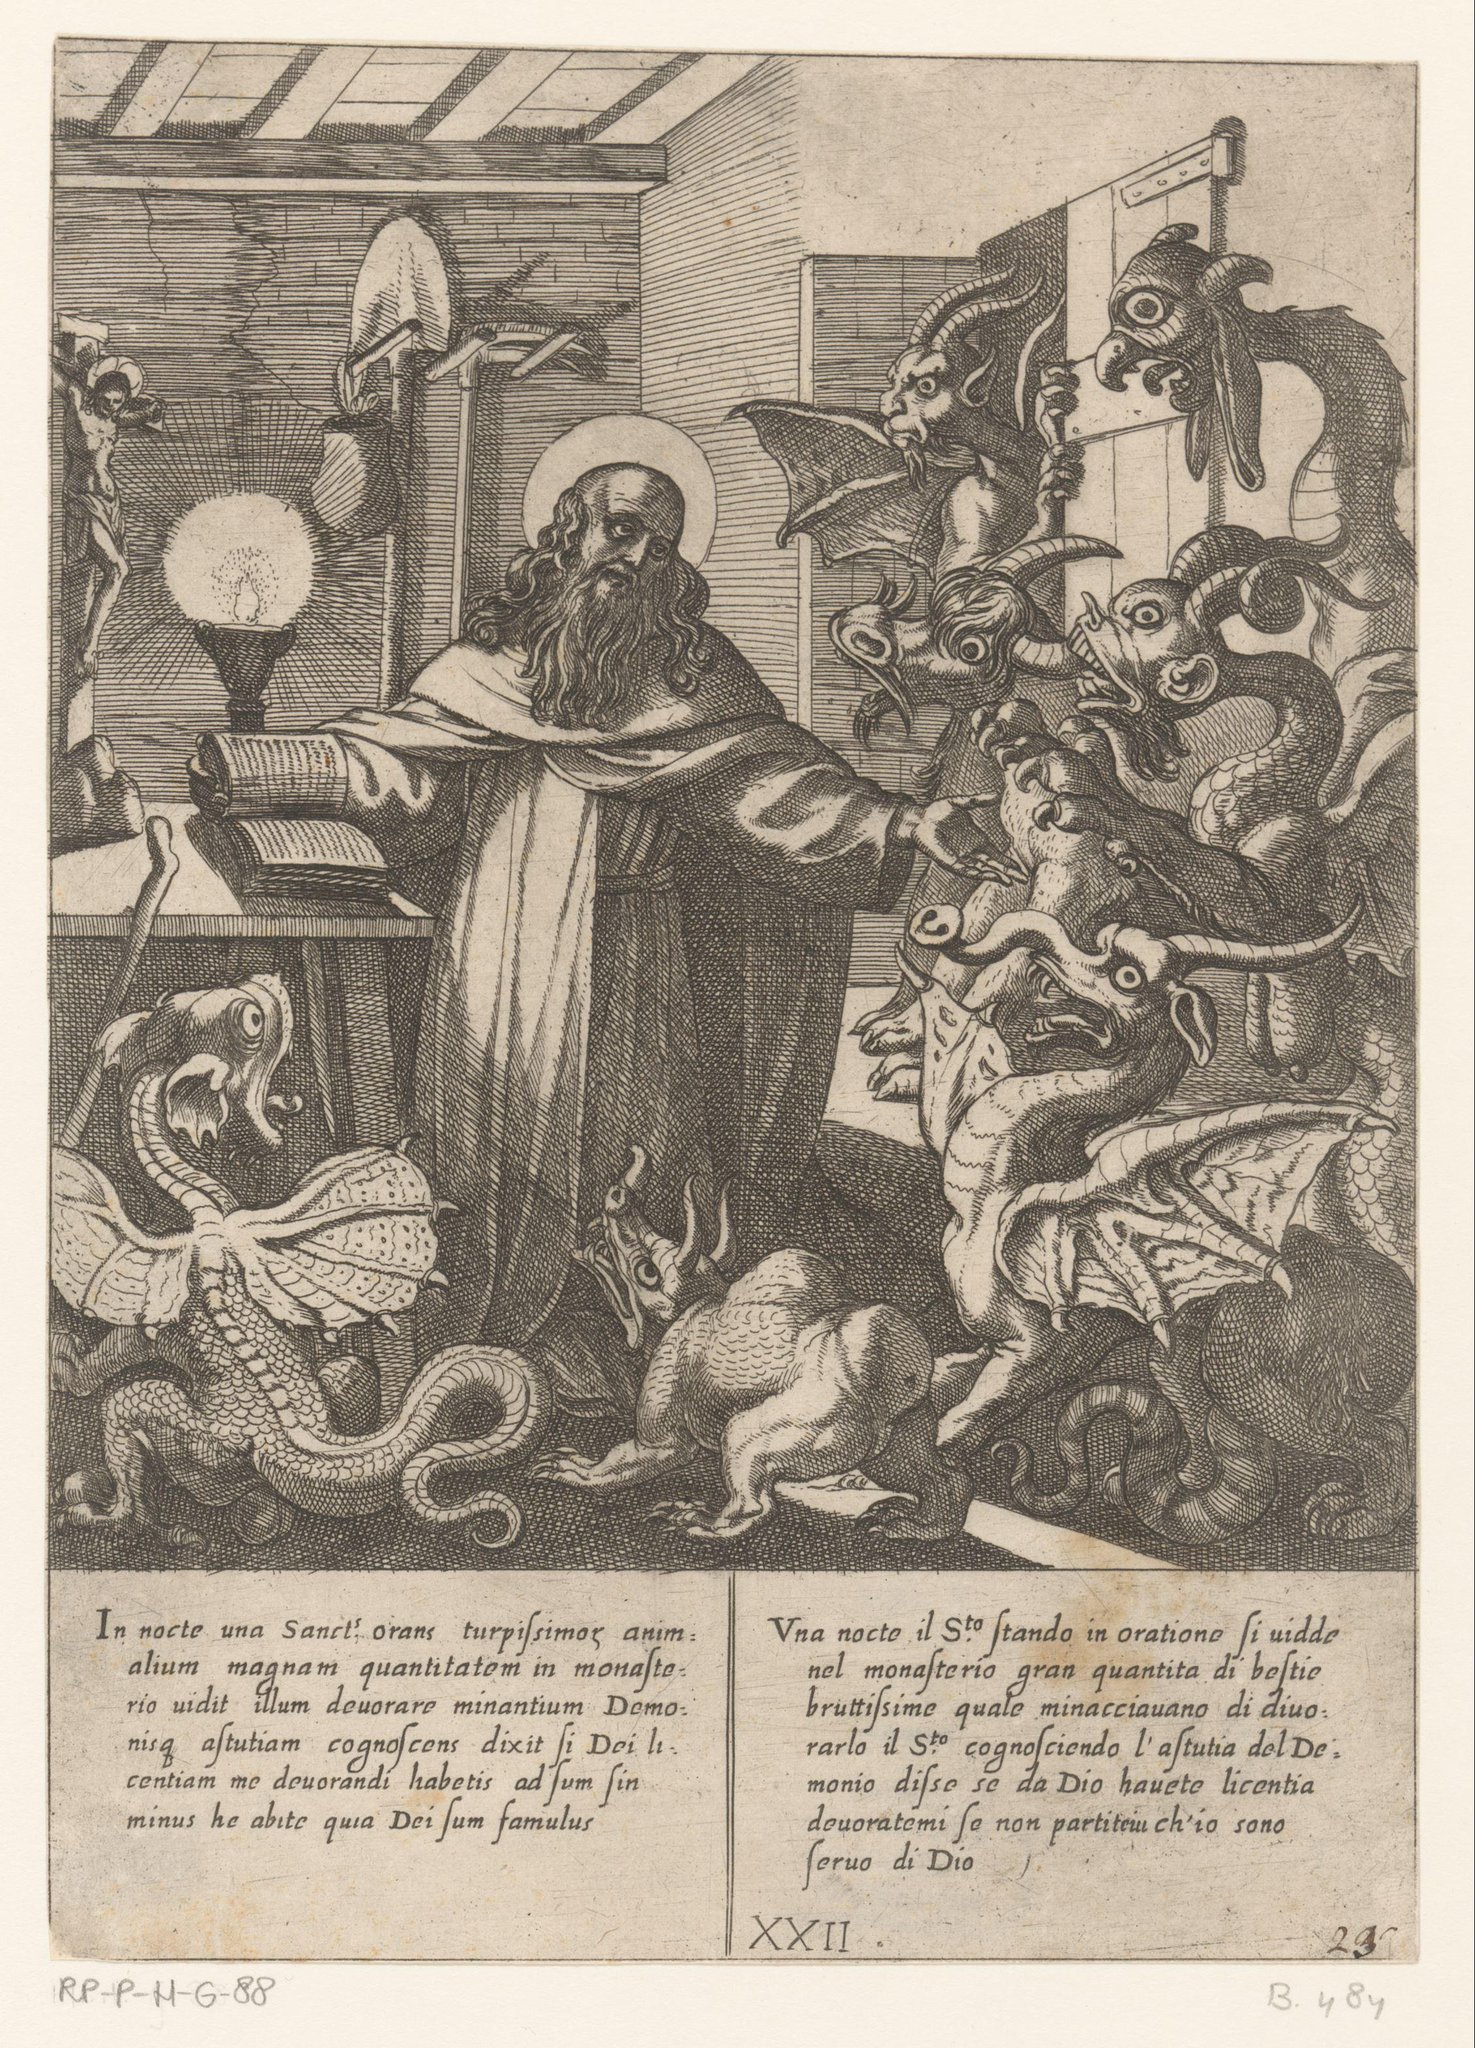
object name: print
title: Demonen dreigen H. Antonius te verslinden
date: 1598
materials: paper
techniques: etching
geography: rome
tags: devil(s) and demons, the hermit antony abbot (antonius abbas) of egypt, also called the great; possible attributes: bell, book, t-shaped staff, flames, pig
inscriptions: collector's mark: Lugt 11, number: ‘23’, collector's mark: ‘Hinloopen’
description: Deze prent maakt deel uit van een reeks van 27 prenten (+ titelprent) over het leven van de heilige Antonius, naar een frescocyclus in de S. Antonio Abbate in Rome door Giovanni Battista Lombardelli en Niccolò Circignani.